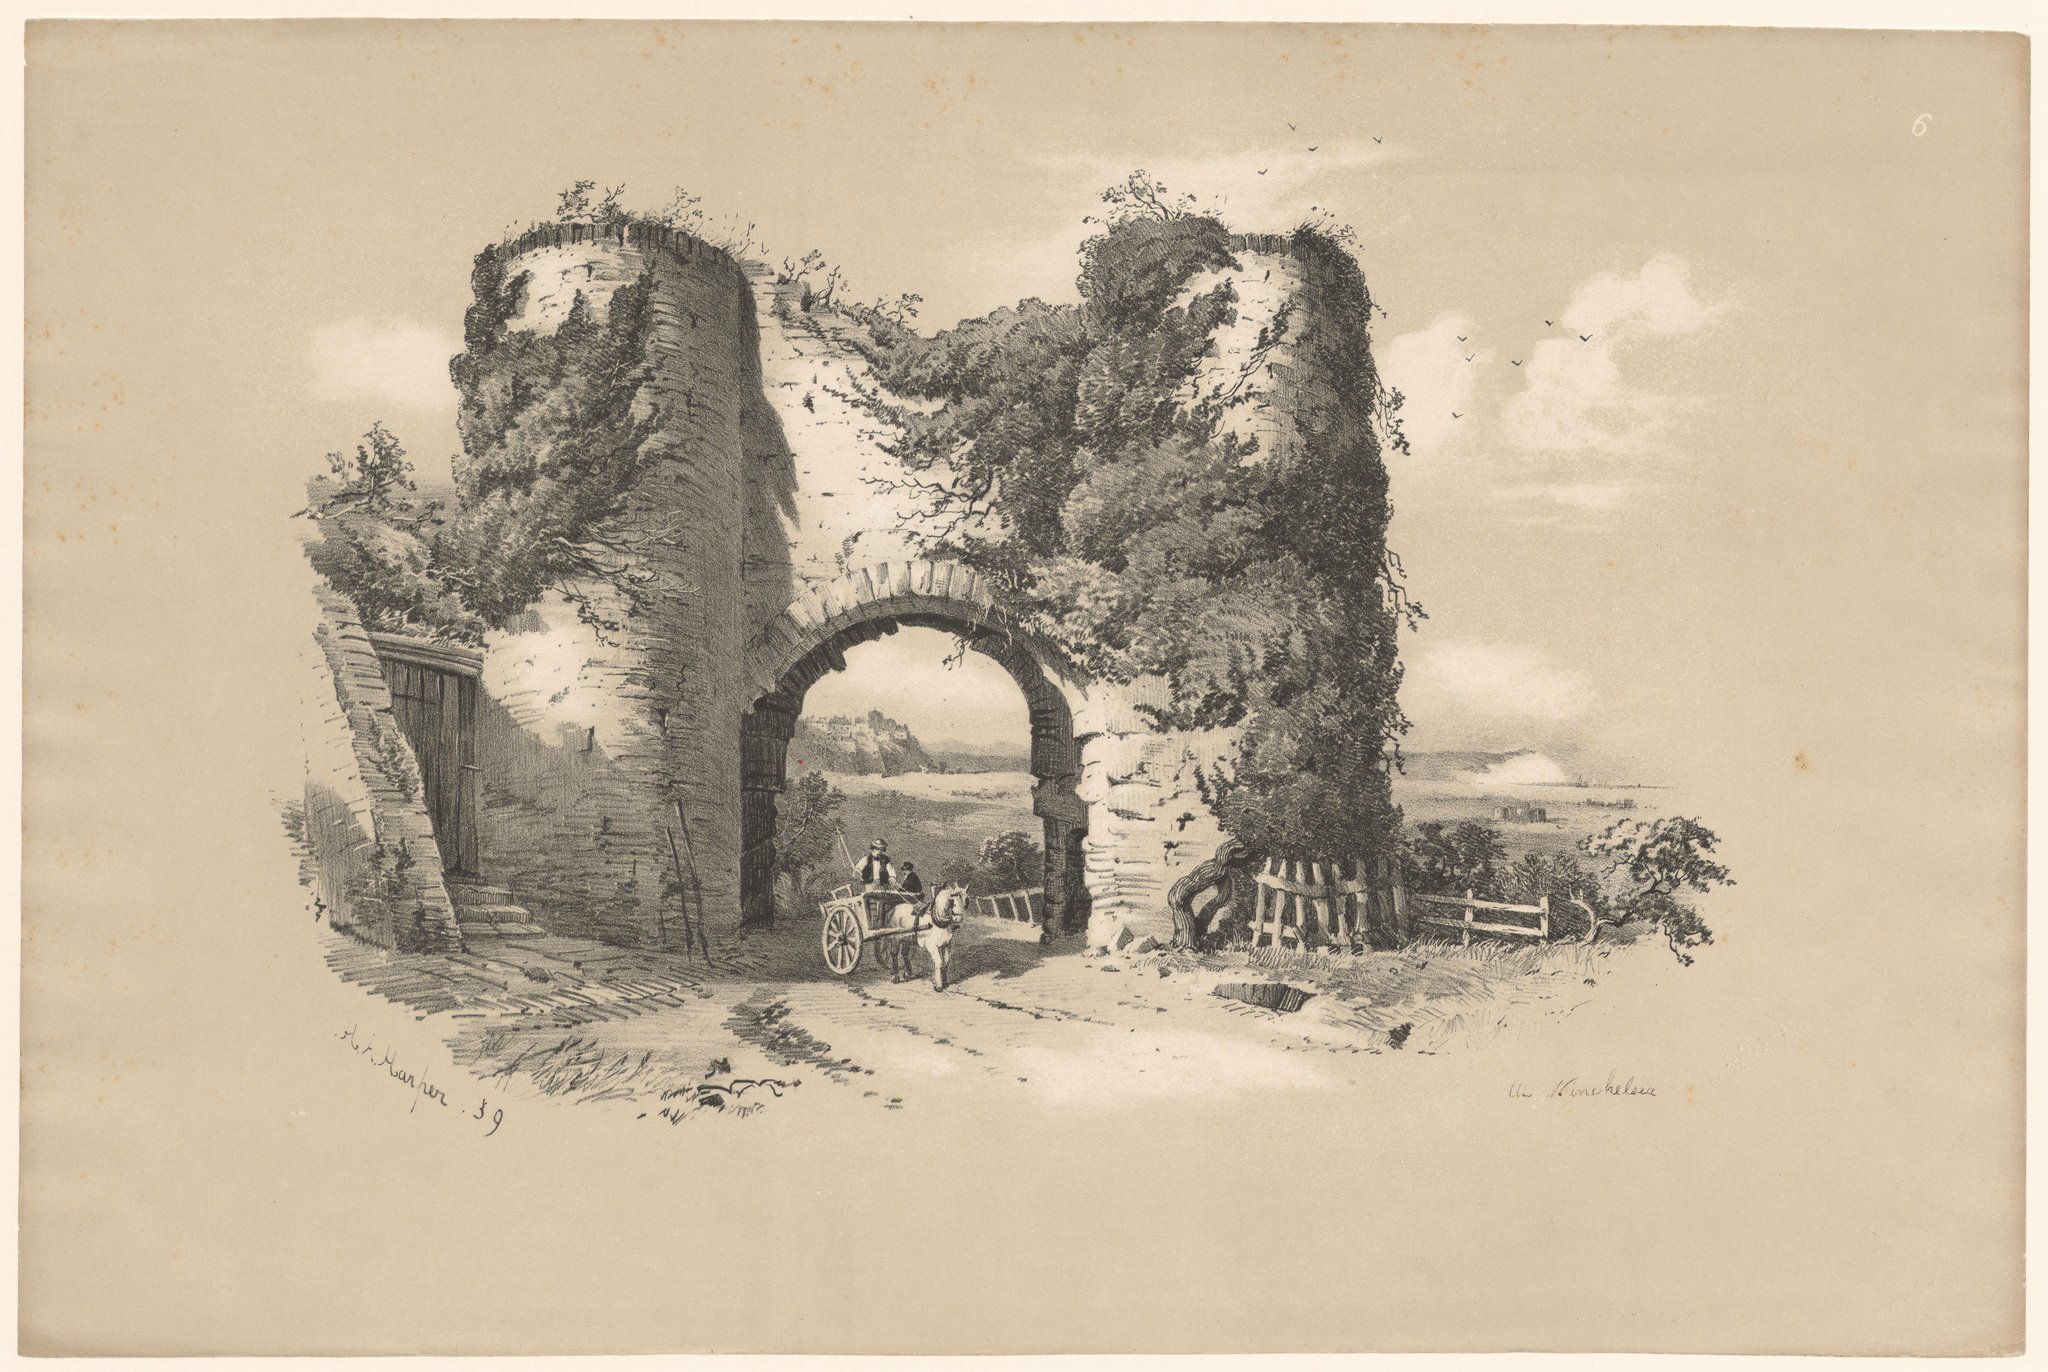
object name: print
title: Paard met wagen bij de Strand Gate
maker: h.a. harper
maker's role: print maker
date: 1839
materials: paper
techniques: tone lithography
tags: gate, entrance, landscape with ruins (+ city(-scape) with figures, staffage), two-wheeled vehicle drawn by one animal